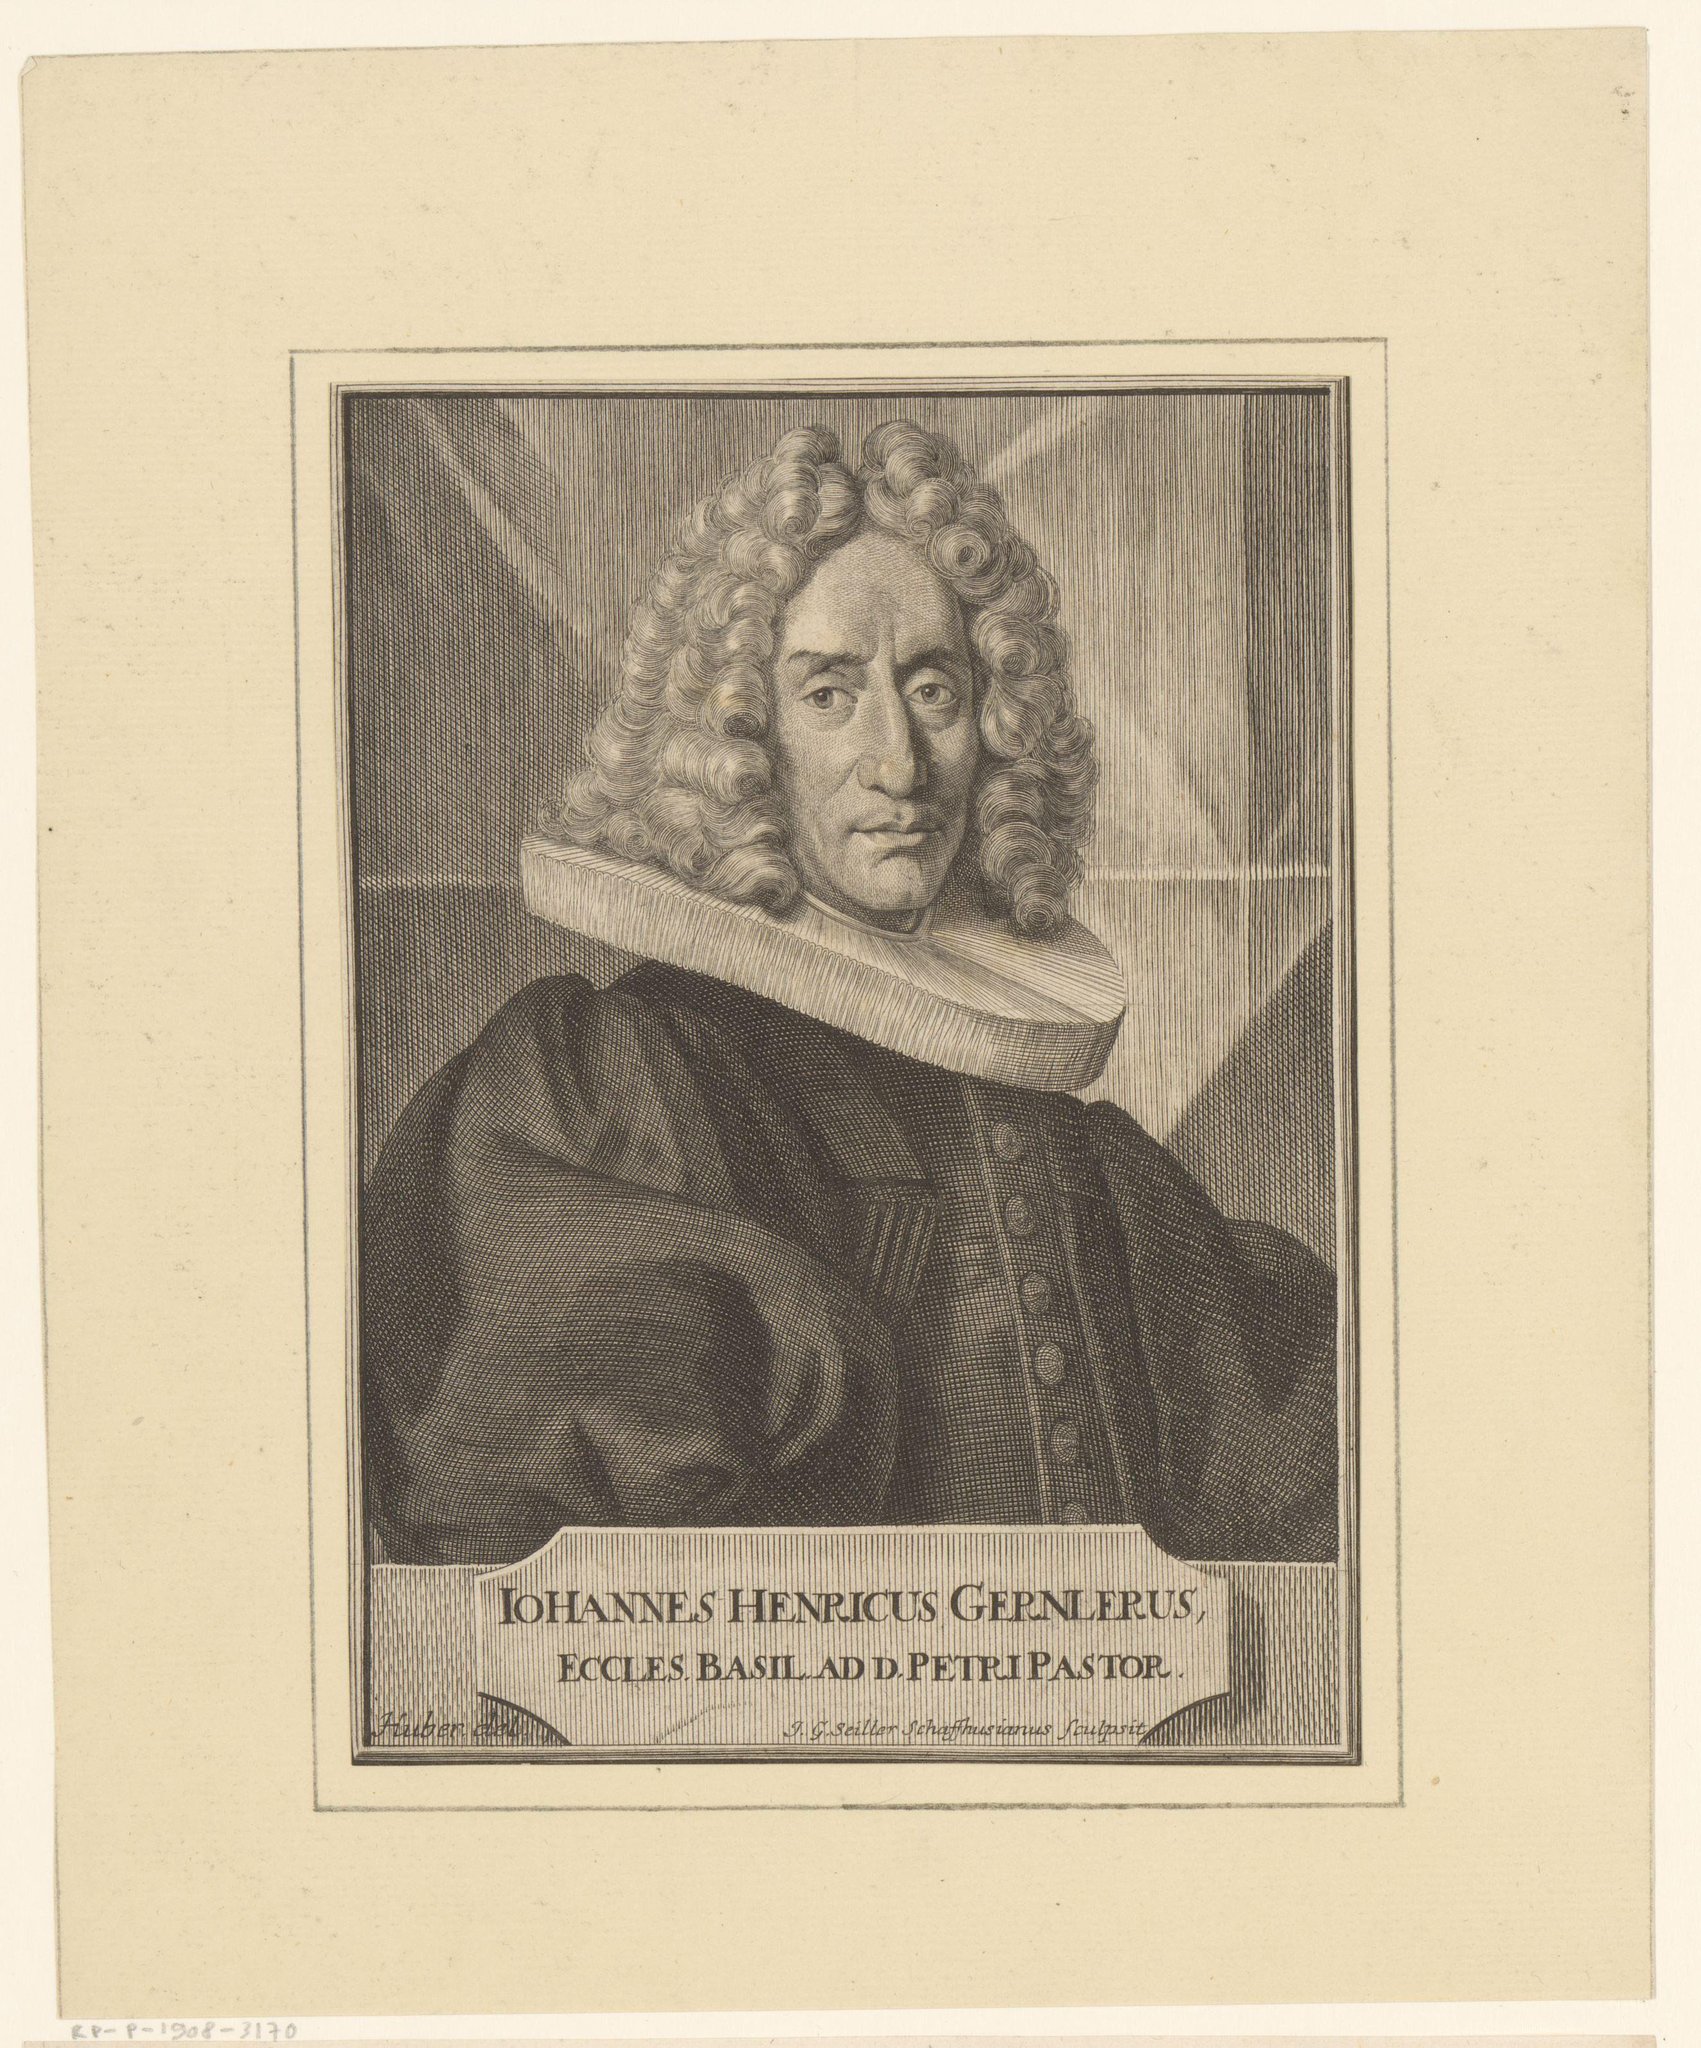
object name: print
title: Portret van Johann Heinrich Gernler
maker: johann georg seiller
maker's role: print maker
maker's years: 1663-1740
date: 1673-1740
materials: paper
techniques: engraving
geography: schaffhausen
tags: theologian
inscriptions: collector's mark: Lugt 2228